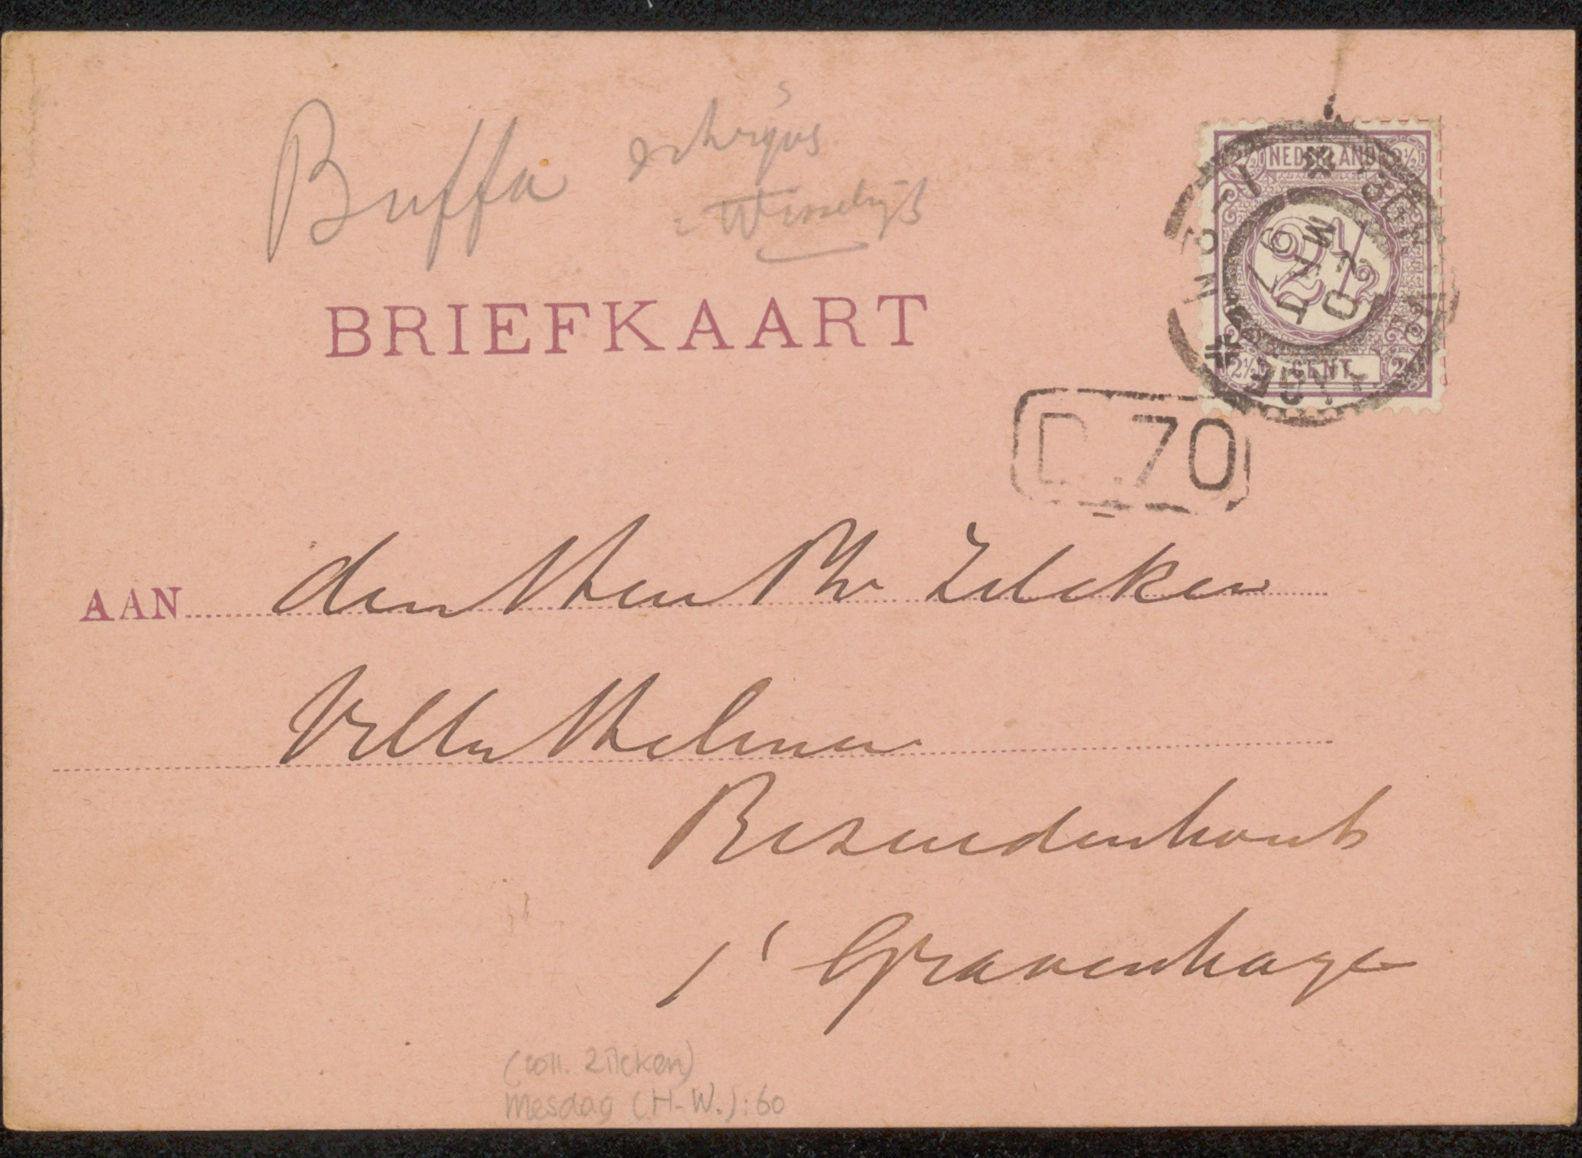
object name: postcard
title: Briefkaart aan Philip Zilcken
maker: hendrik willem mesdag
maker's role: draughtsman, painter, print maker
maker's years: 1831-1915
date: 1897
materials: cardboard, ink, pencil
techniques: pen, writing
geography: the hague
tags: the hague, draughtsman, philip zilcken, exhibition ~ art